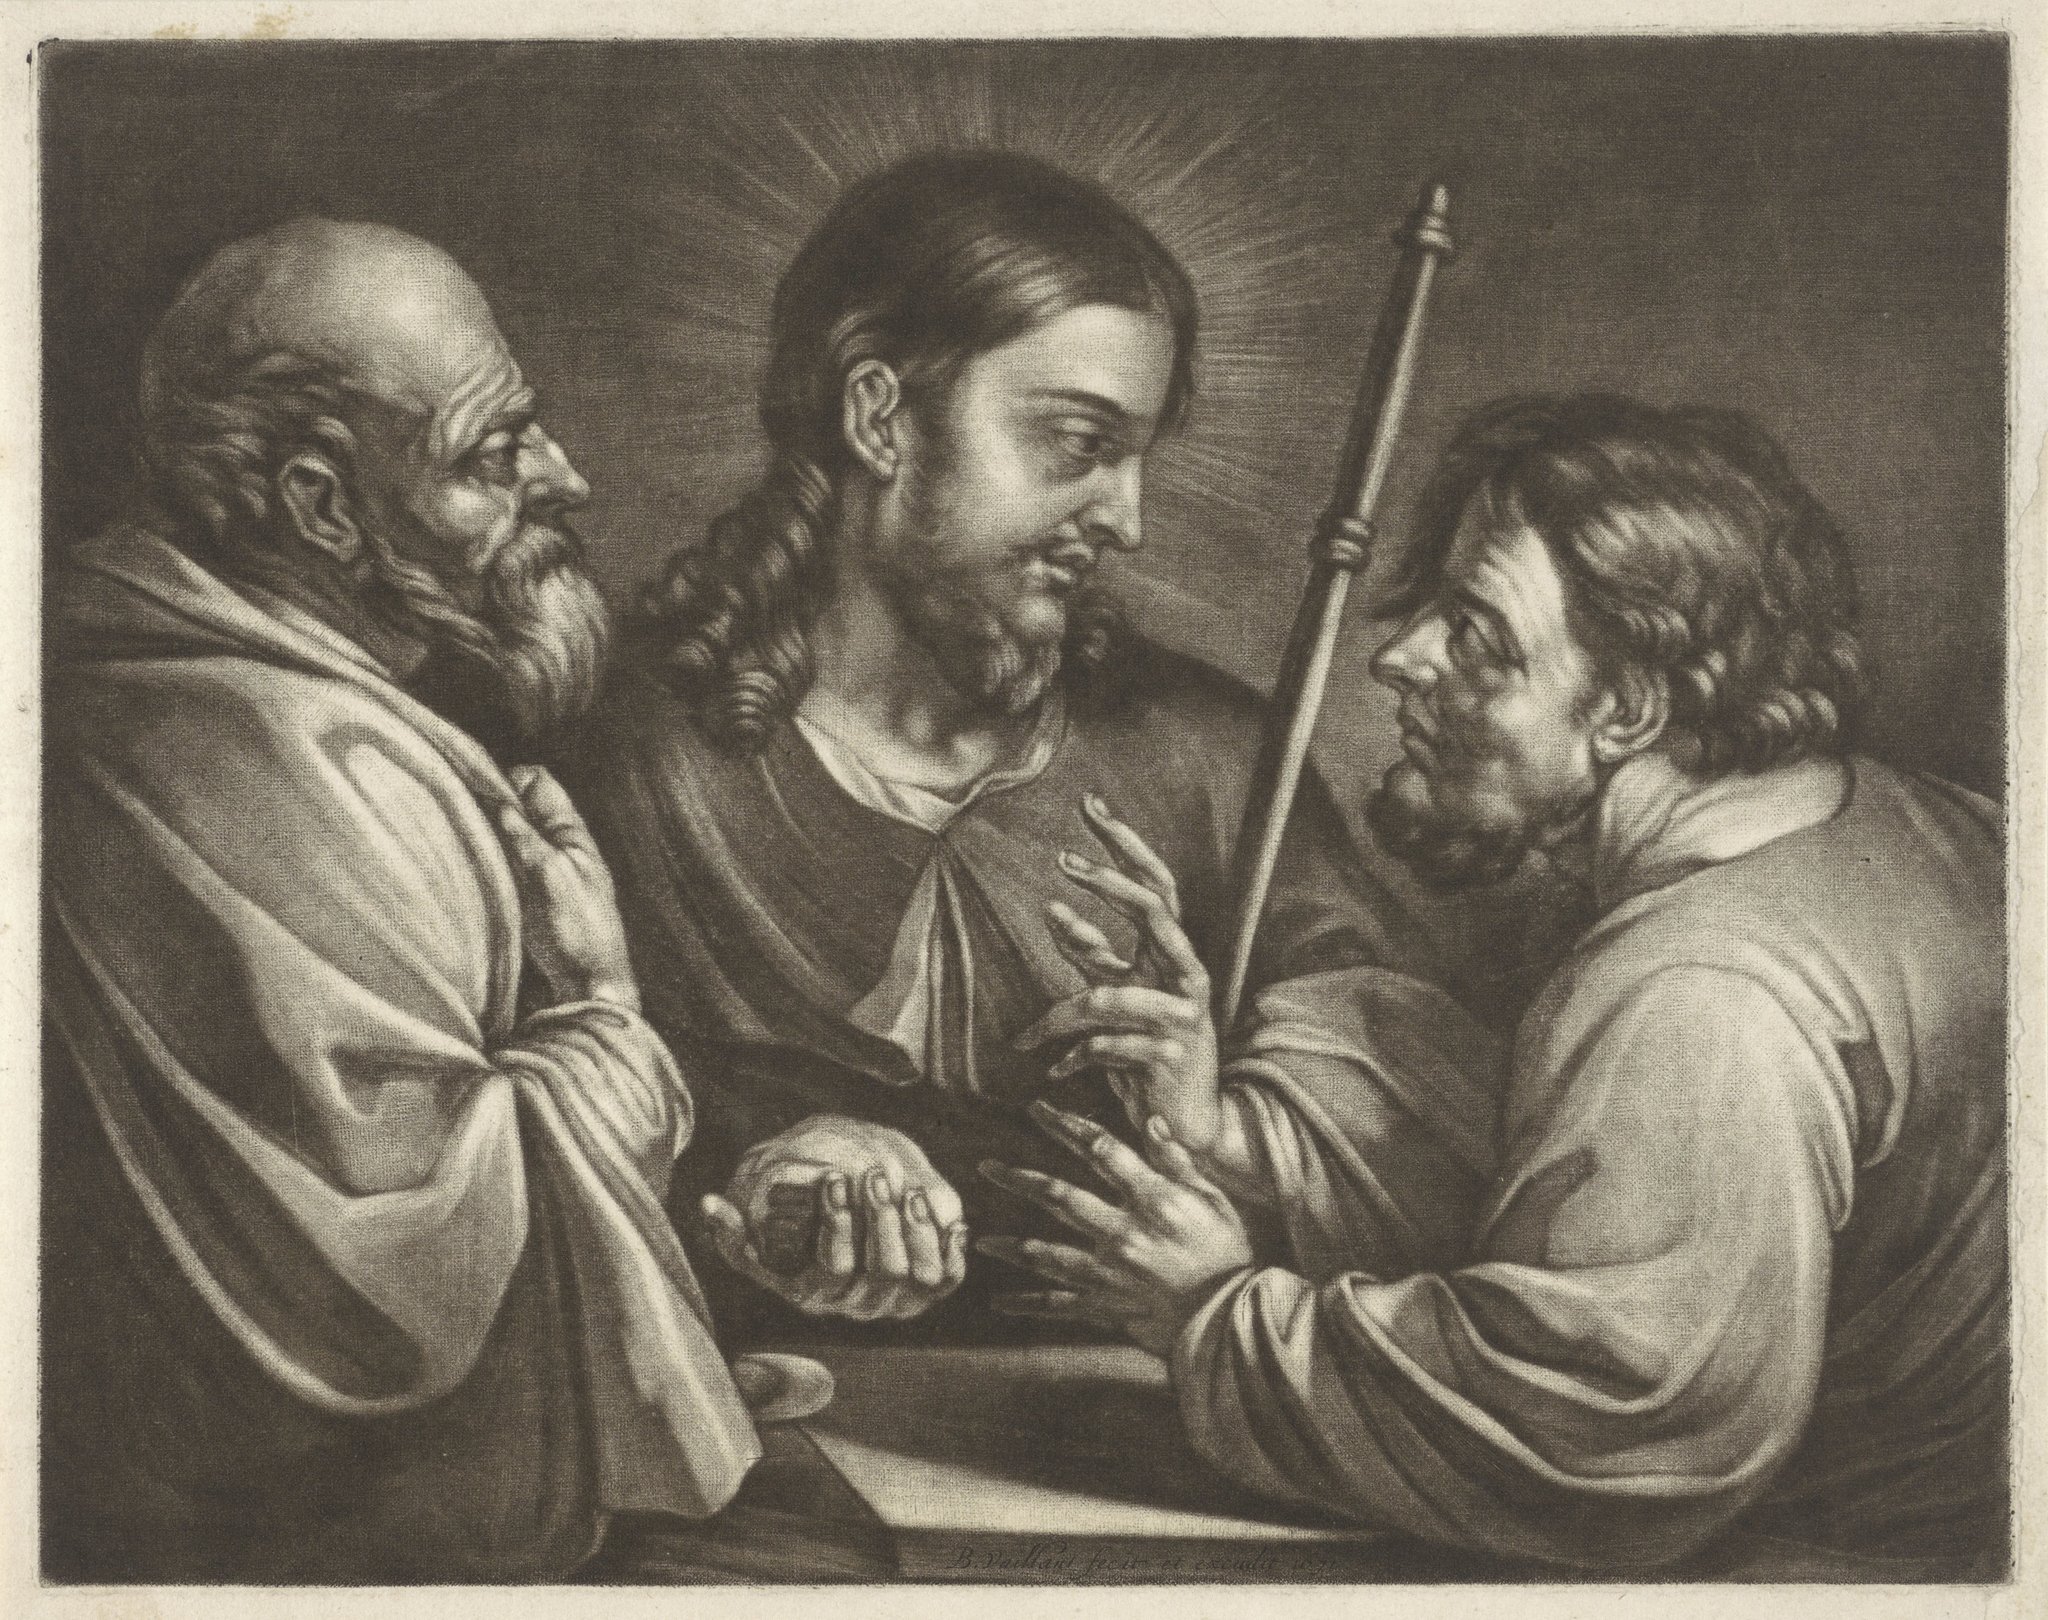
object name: print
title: Maaltijd te Emmaüs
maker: bernard vaillant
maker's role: draughtsman, painter, print maker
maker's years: 1632-1698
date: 1671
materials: paper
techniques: mezzotint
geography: amsterdam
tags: the supper at emmaus: christ is recognized while blessing or breaking the bread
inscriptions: collector's mark: Lugt 2228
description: Christus zit met de Emmaüsgangers aan tafel. Hij breekt het brood en spreekt de zegen uit en op dat moment herkennen de twee mannen hem.